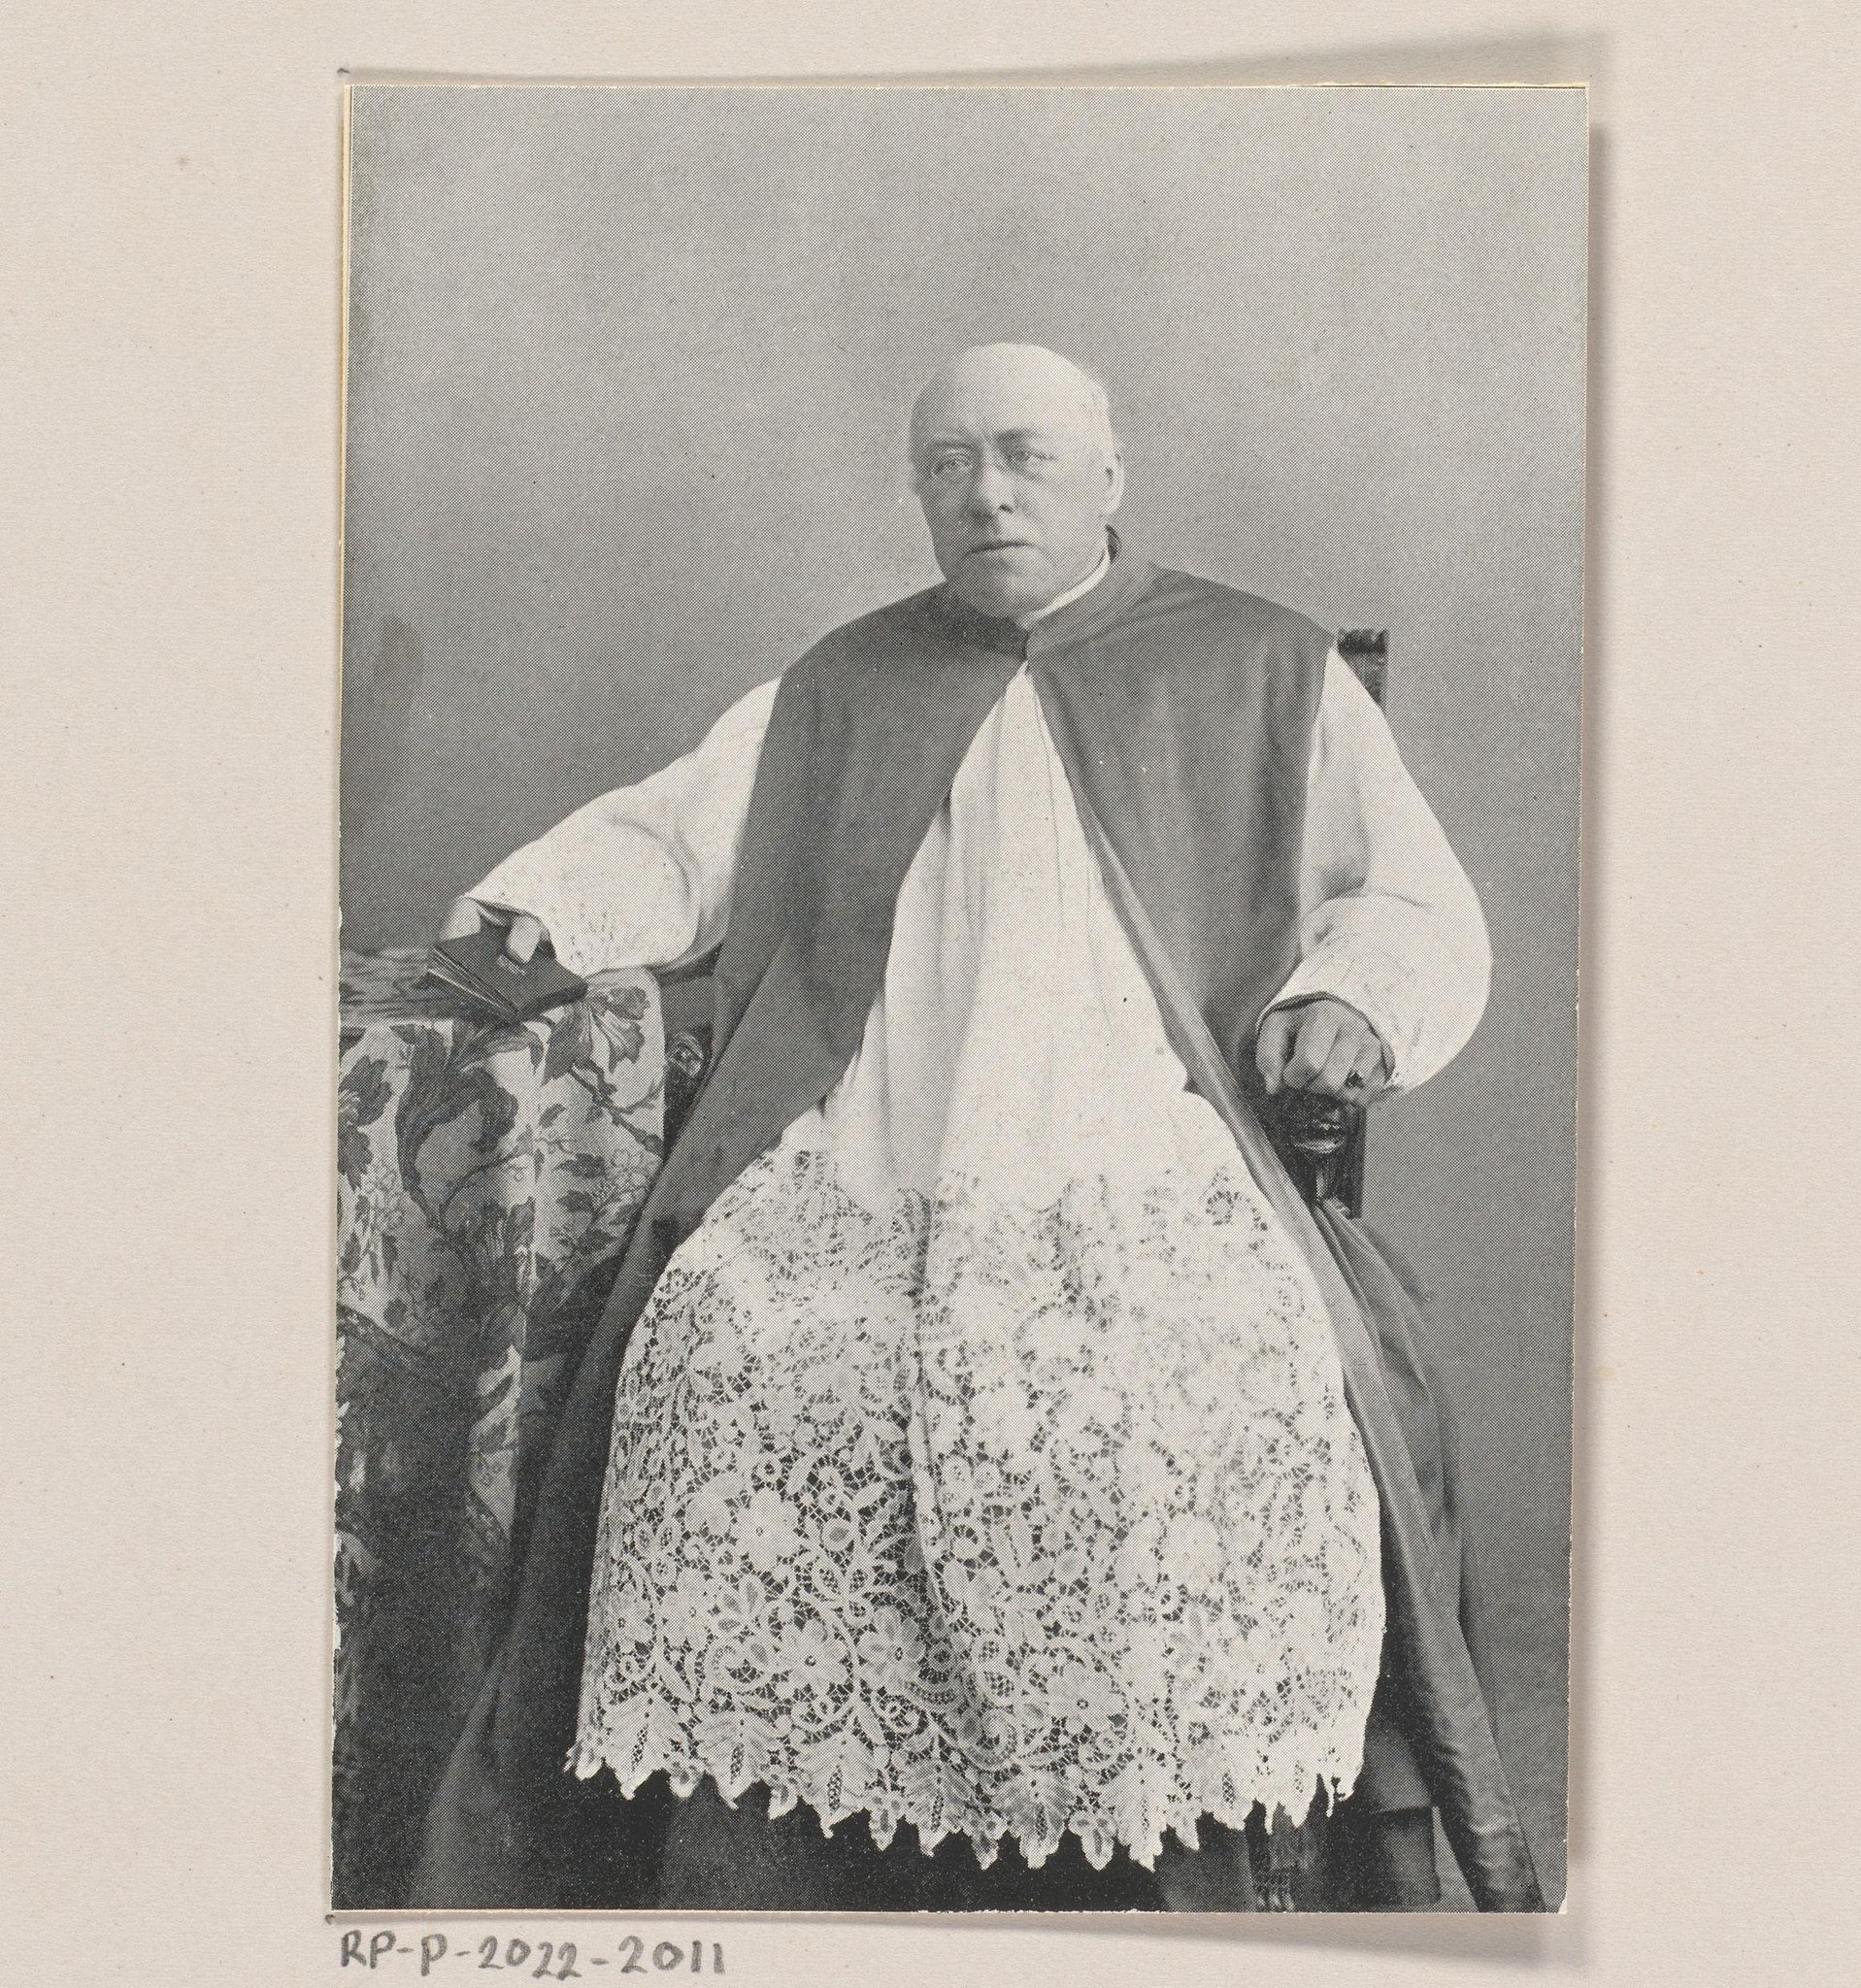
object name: photomechanical print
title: Portret van Andreas Ignatius Schaepman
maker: Anonymous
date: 1882-1970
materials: paper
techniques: autotype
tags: archbishop, bishop, etc. (roman catholic), historical persons